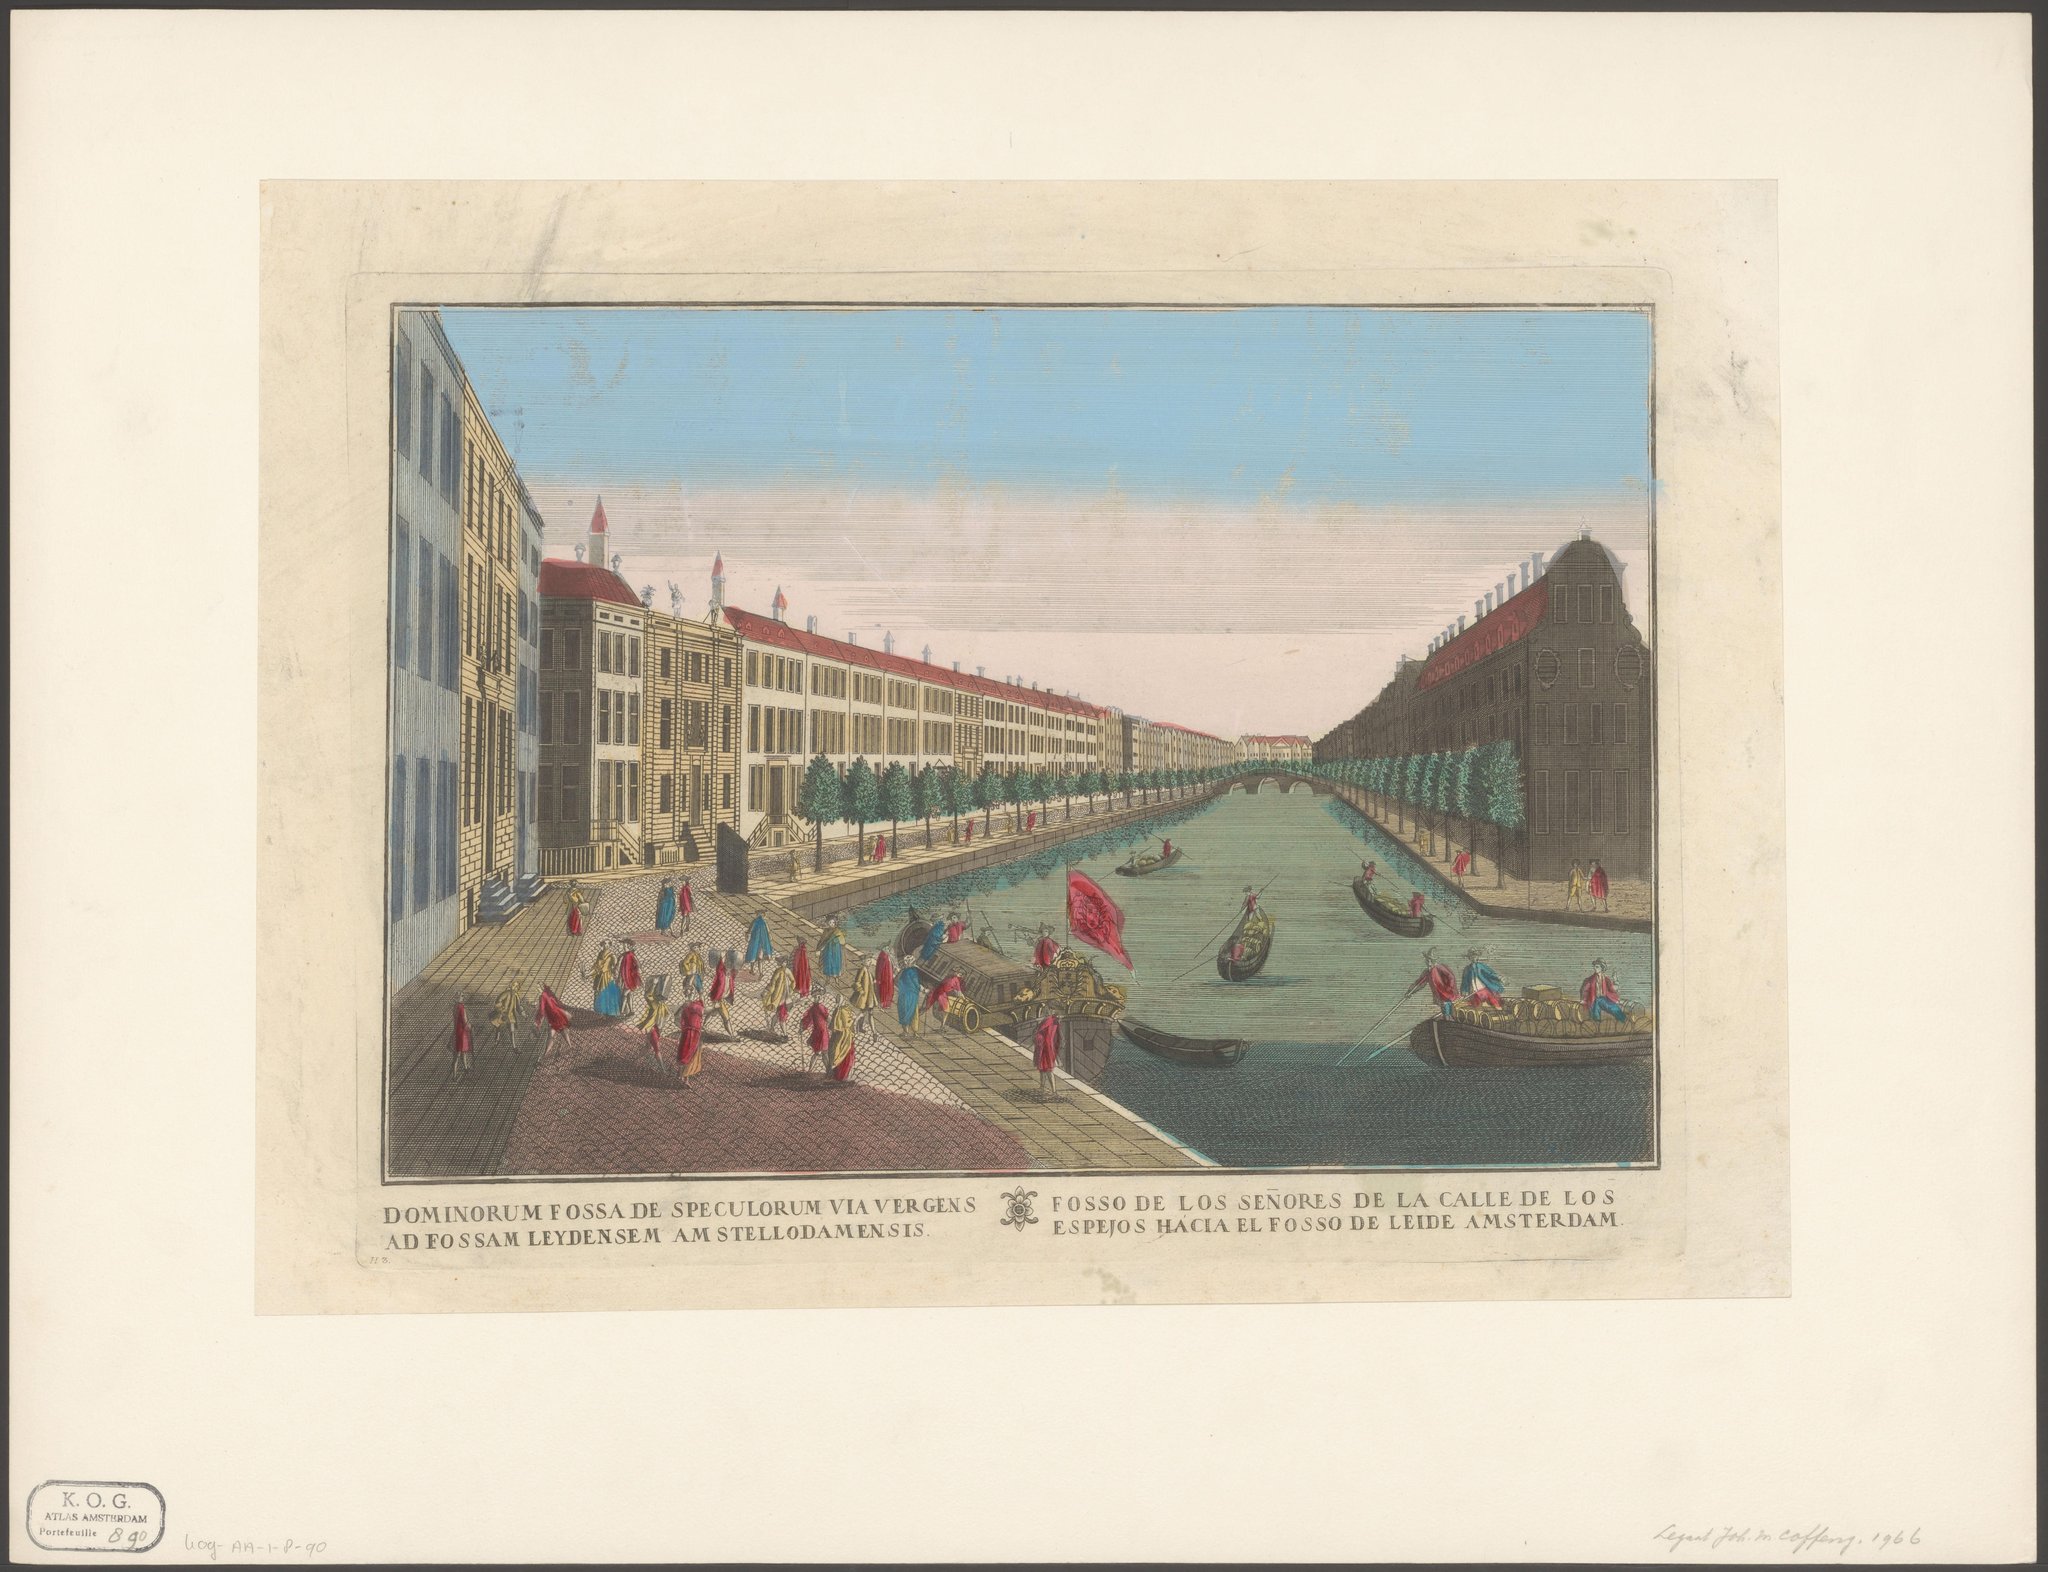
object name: print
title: Dominorum fossa de speculorum via vergens / ad fossam leydensem amstellodamensis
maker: Anonymous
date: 1800-1899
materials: paper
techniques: etching, hand coloring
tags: city-view in general; 'veduta', canal, bridge in city across river, canal, etc., two-wheeled vehicle drawn by two animals, street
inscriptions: inscription: ‘Legaat Joh. M. Coffeng, 1966’, collector's mark: ‘8,90’ Lugt 1641b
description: Onderwerpsrubriek binnen de Atlas Amsterdam: Haarlemmerplein, Halvemaansteeg, Handboogstraat, Handelskade, Haringpakkerij, Hartenstraat, Hasseltsteeg (Dirk van), Heerengracht.